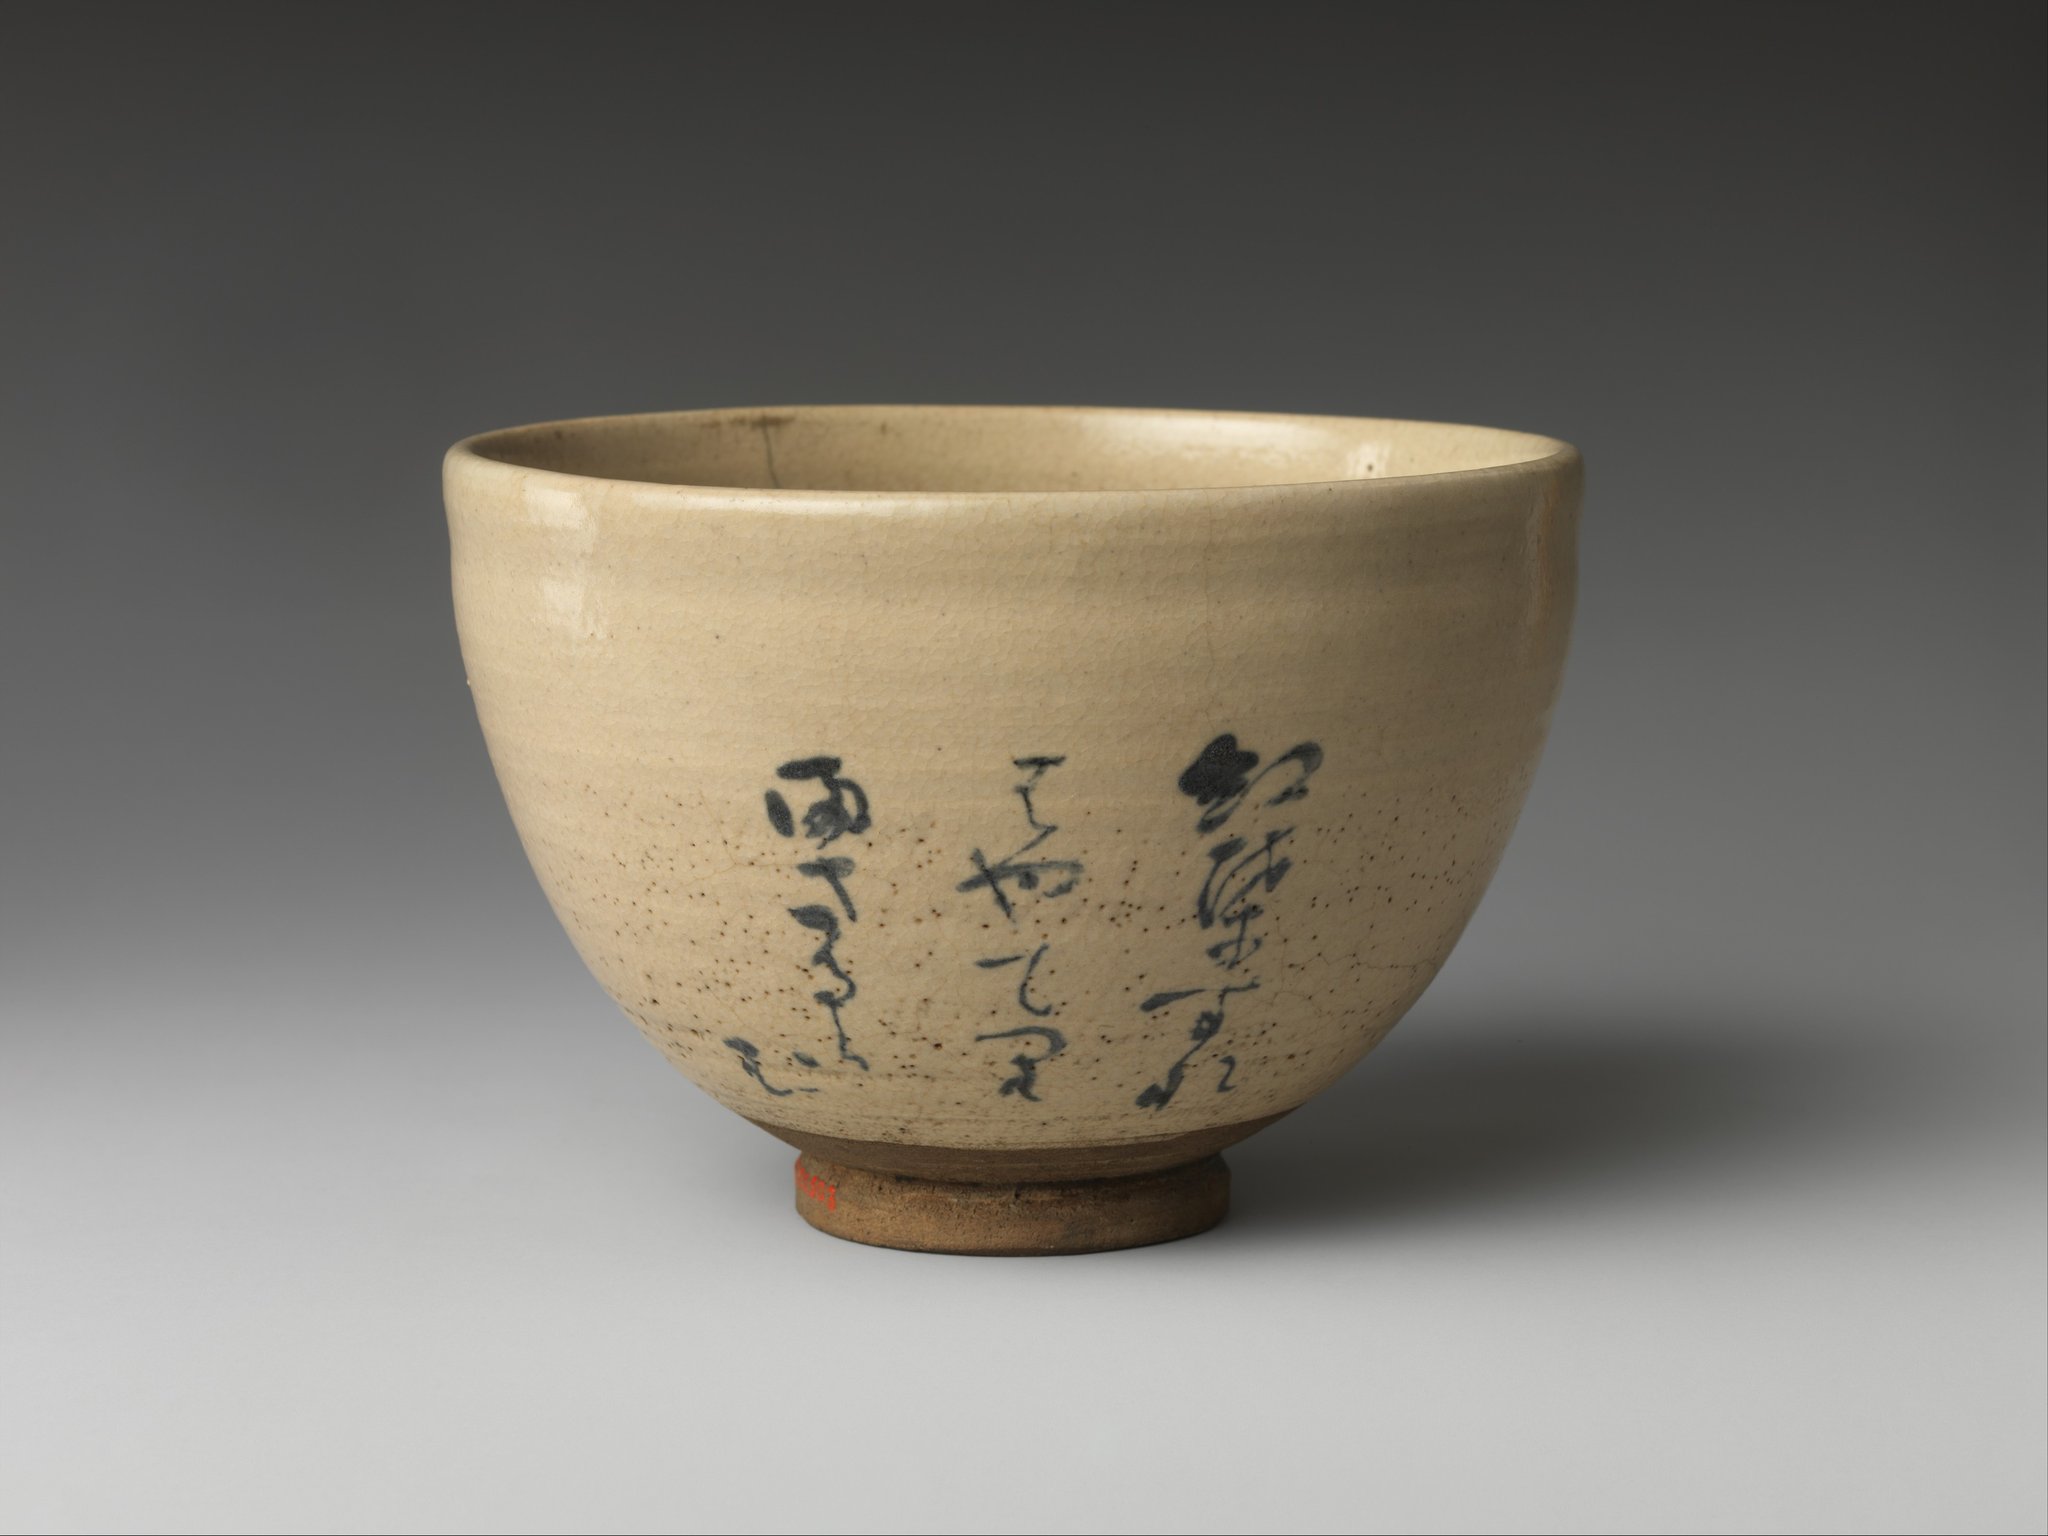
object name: teabowl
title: Teabowl with Autumn Poem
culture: japanese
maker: eiraku wazen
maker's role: artist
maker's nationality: japanese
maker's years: 1823-1896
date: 1851-1900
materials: cobalt, glaze, stoneware